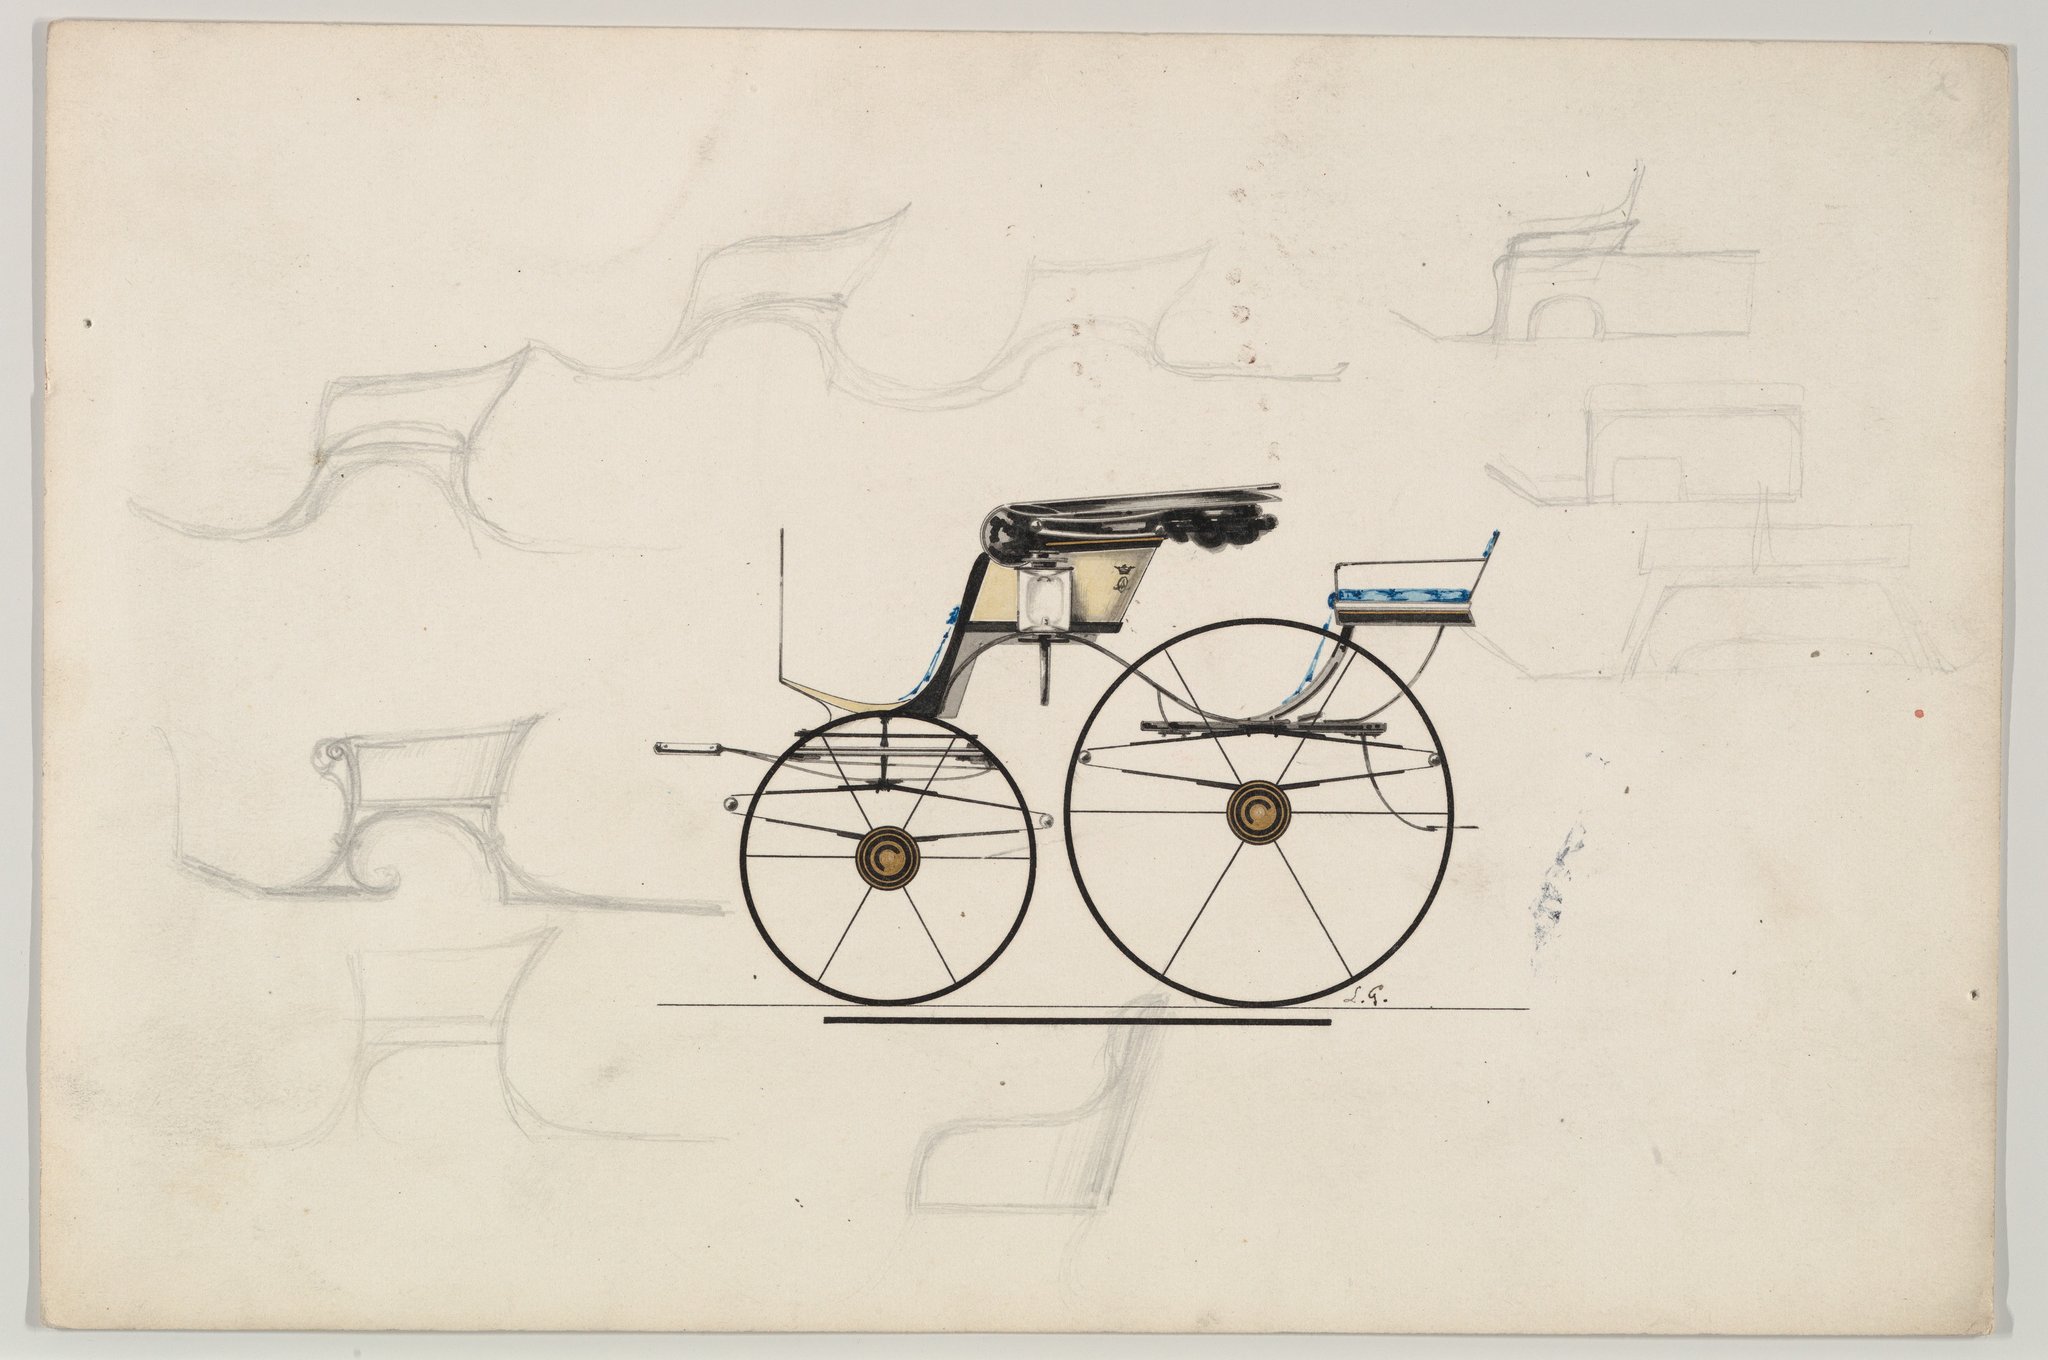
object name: drawing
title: Spider Phaeton (unnumbered)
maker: brewster & co.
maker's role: manufacturer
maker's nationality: american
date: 1870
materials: gouache, graphite, ink, watercolor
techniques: pen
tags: carriages